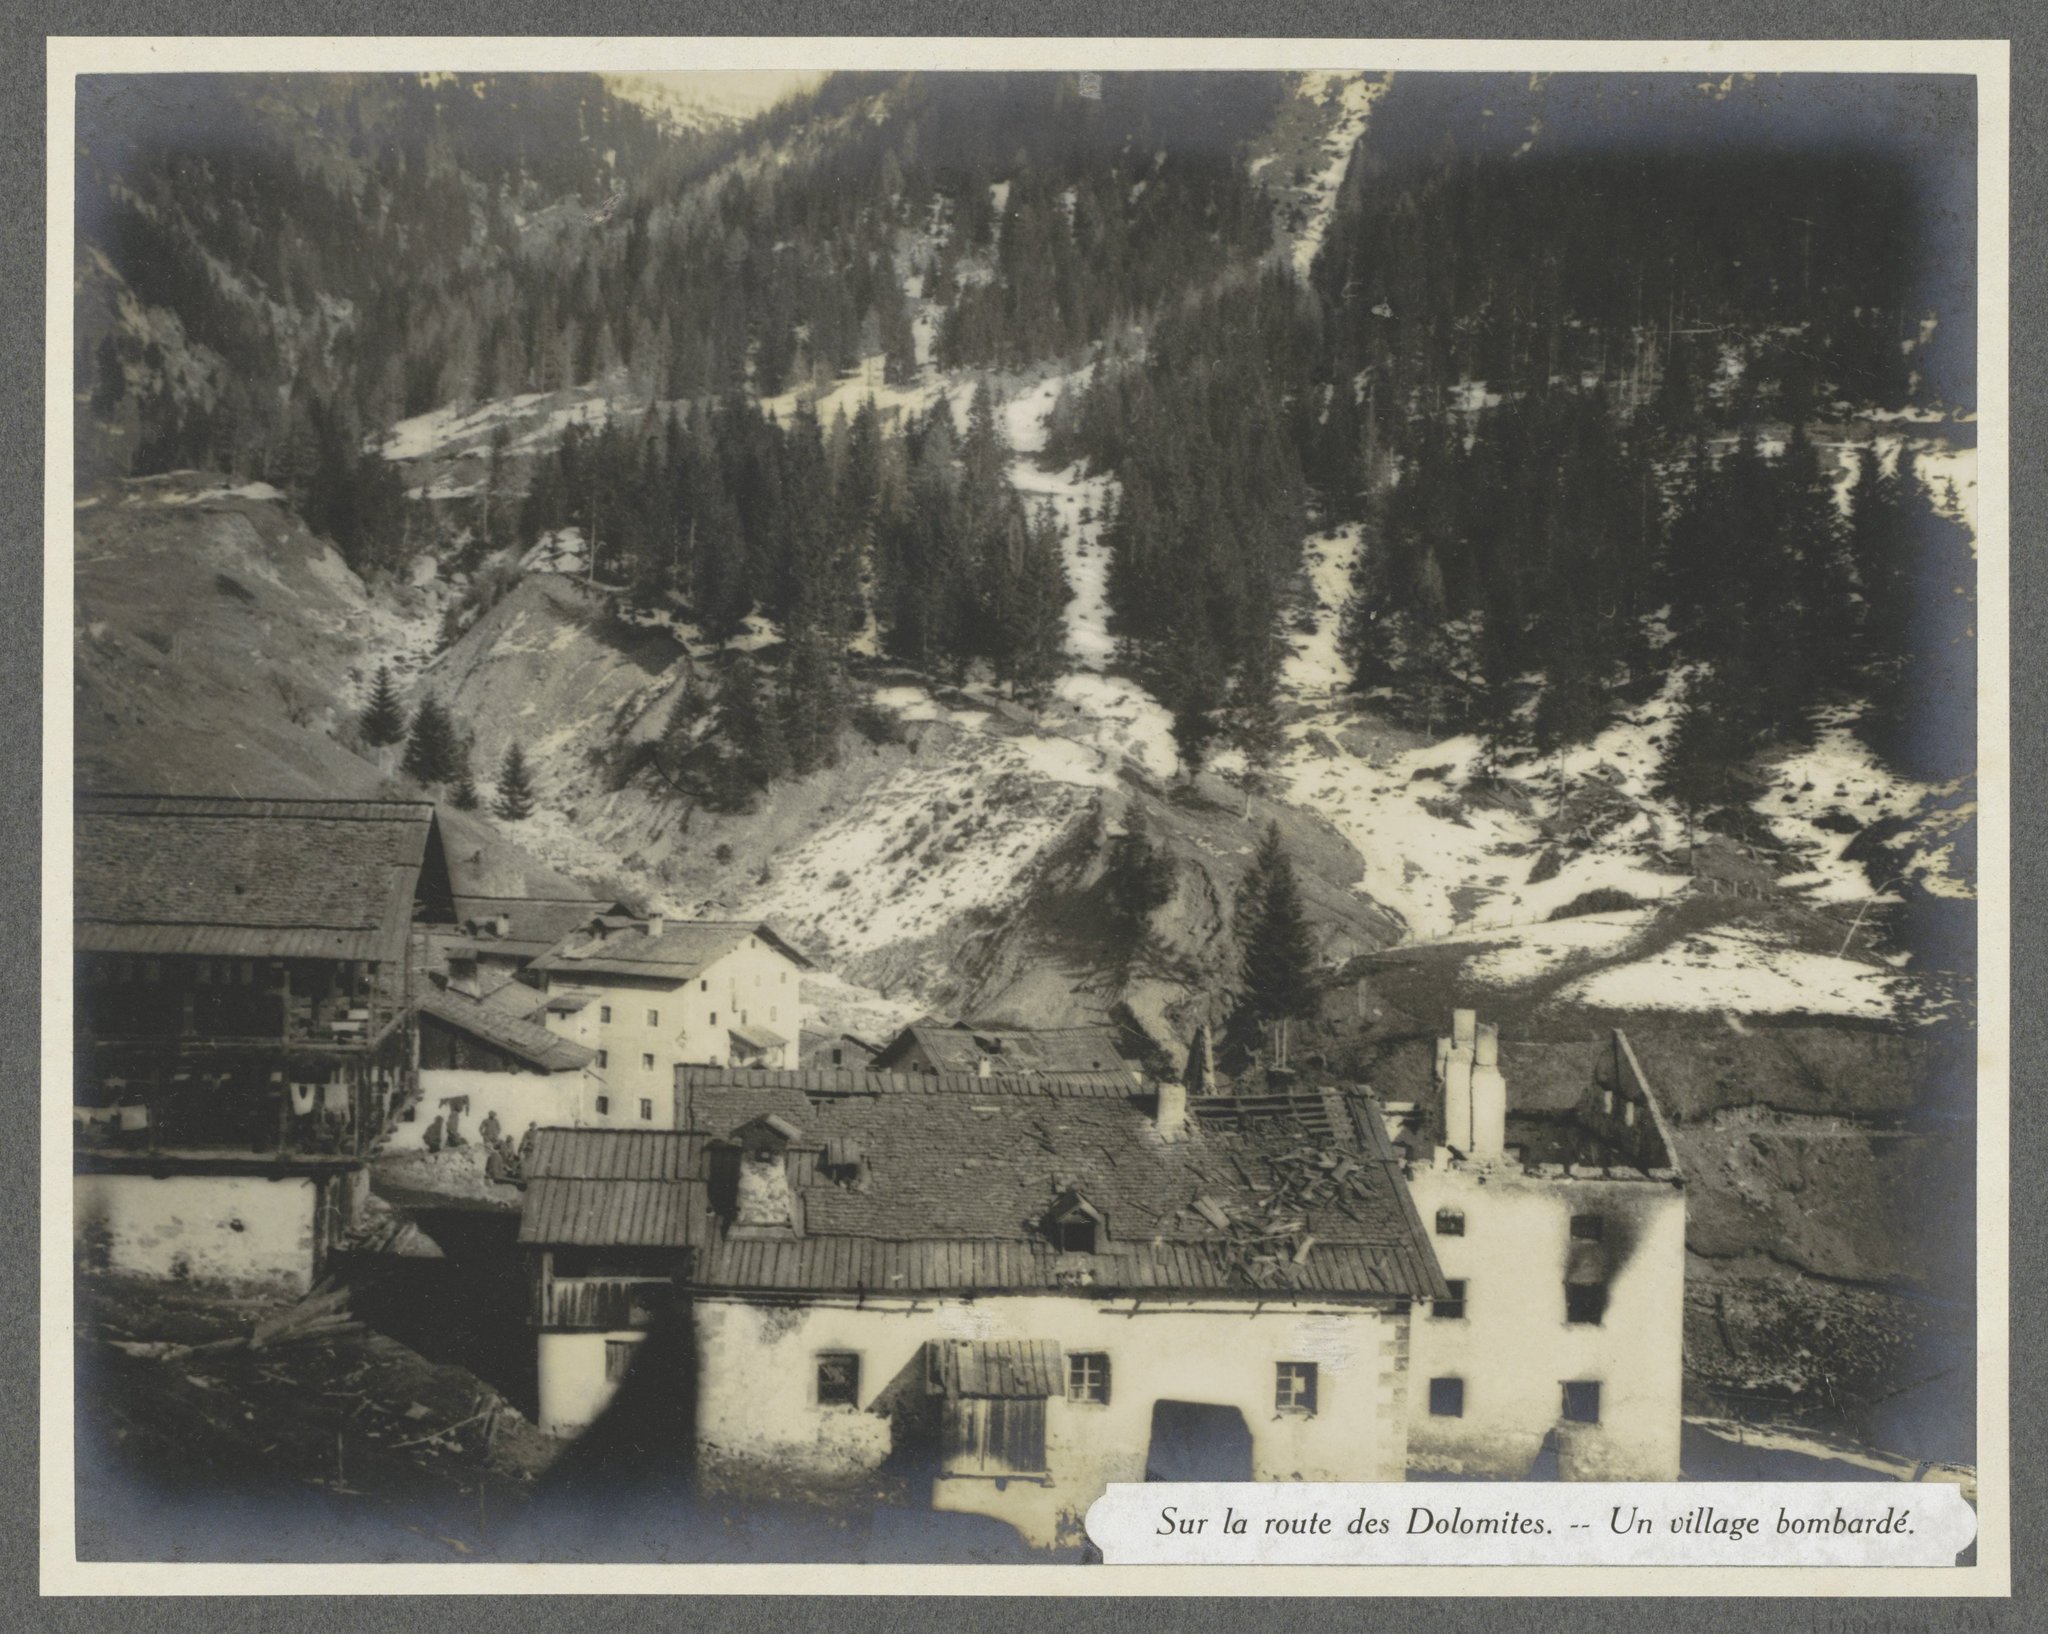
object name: photograph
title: Sur la route des Dolomites. -- Un village bombardé.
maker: henri de rothschild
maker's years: 1872-1947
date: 1916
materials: photographic support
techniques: gelatin silver print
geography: dolomites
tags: prospect of village, silhouette of village, war (+ land forces), mountains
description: Onderdeel van Fotoalbum Medische missie H. de Rothschild naar het Italiaanse front 1916.